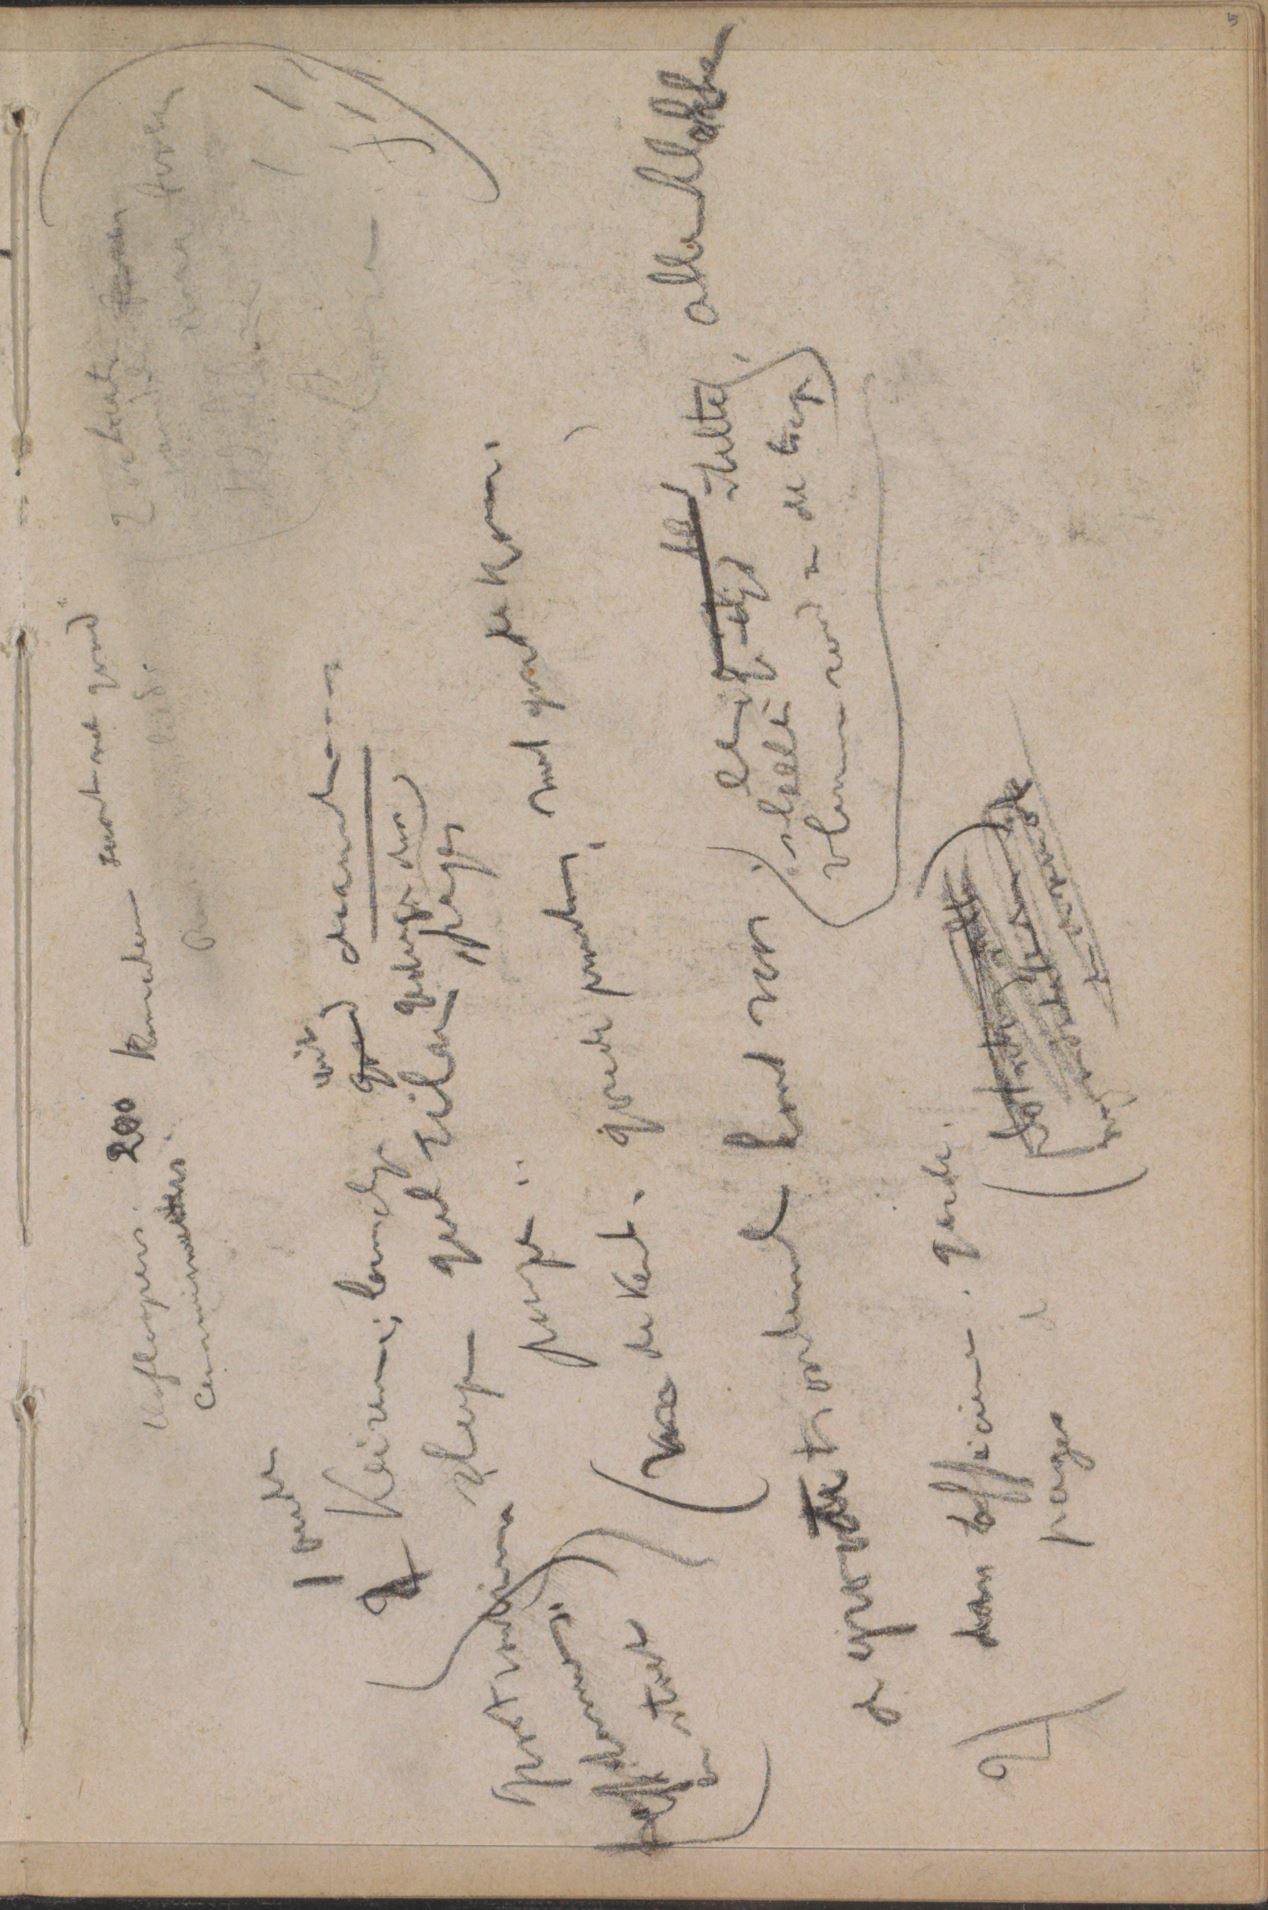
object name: sketchbook leaf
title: Blad met notities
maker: marius bauer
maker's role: draughtsman, print maker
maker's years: 1867-1932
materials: chalk, paper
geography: moscow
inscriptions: annotation: ‘Hofloopers 200/ [...]’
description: Pagina 13 uit een schetsboek met 54 bladen.